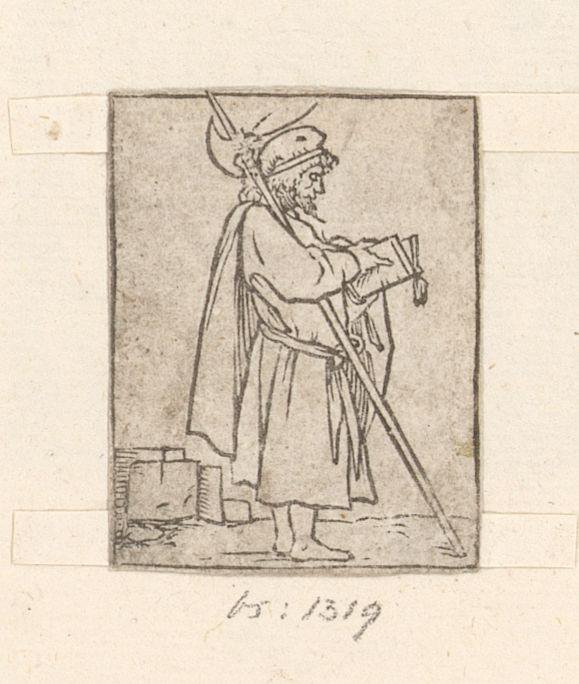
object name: print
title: Matteüs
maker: hans holbein (der jüngere)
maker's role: draughtsman, painter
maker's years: 1497-1543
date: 1507-1543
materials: paper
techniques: woodcut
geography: switzerland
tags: the apostle and evangelist matthew (mattheus); possible attributes: angel, axe, book, halberd, pen and inkhorn, purse, scroll, square, sword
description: De apostel Matteüs lezend in een boek met hellebaard in de arm. Prent maakt deel uit van een album.